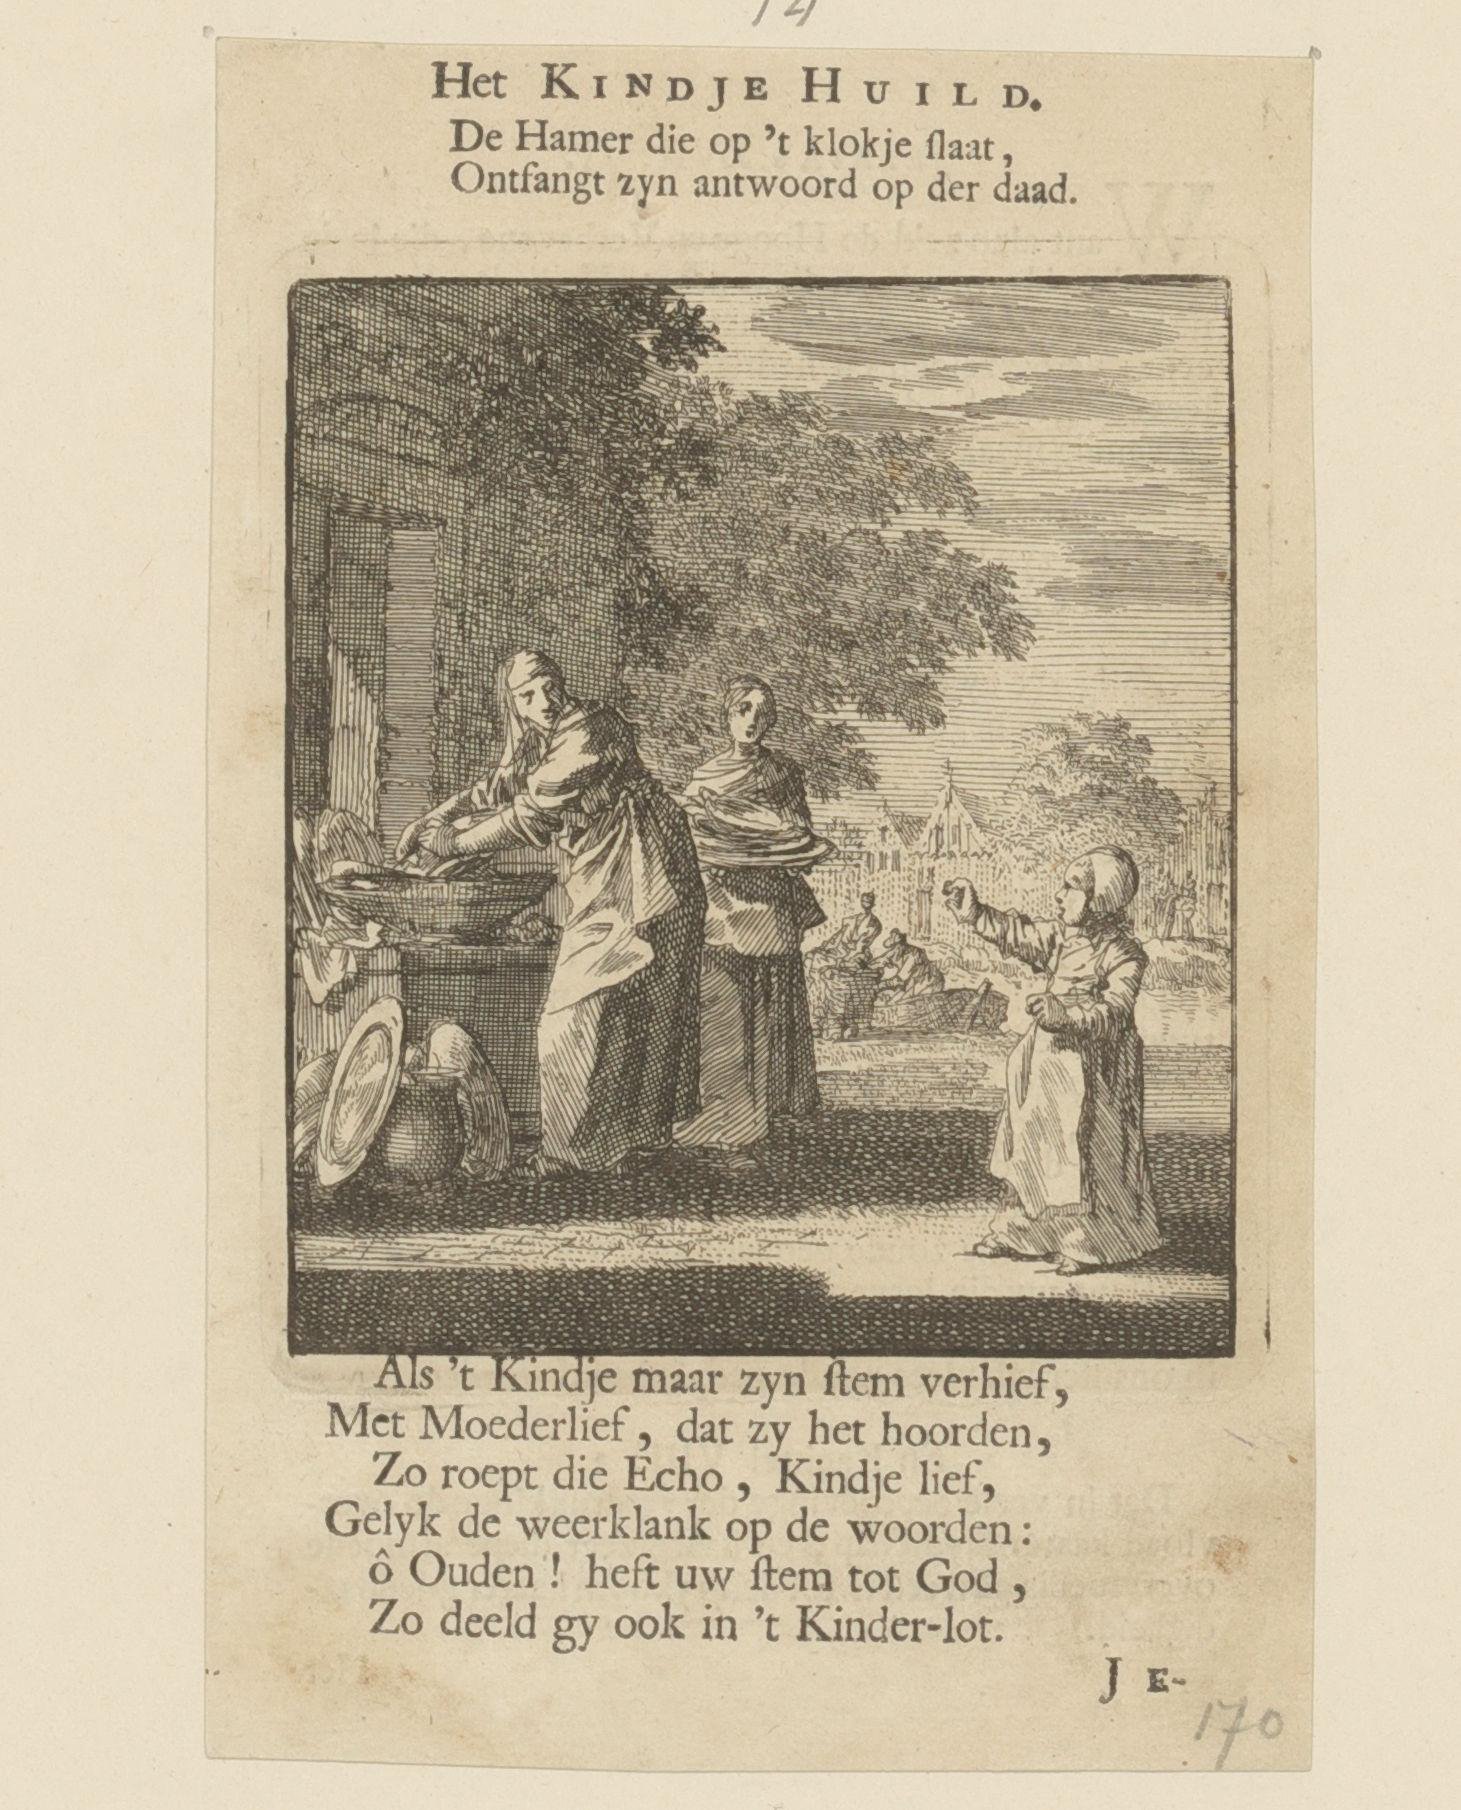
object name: print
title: Het Kindje Huild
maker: jan luyken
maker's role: draughtsman, print maker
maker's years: 1649-1712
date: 1712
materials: paper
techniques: etching, letterpress printing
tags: weeping, crying, shouting, mother and daughter(s) (family group)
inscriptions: stamp, collector's mark: Lugt 1641, stamp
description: Kind roept haar moeder die bezig is met het wassen van vaatwerk. Onderaan een zesregelig vers. Onderwerpsrubrieken binnen de Atlas Zeden en Gewoonten: Zeden en Gewoonten in Engeren Zin, Des menschen beging, midden en einde, Kinderleven – Kinderspel en Kinderprenten.